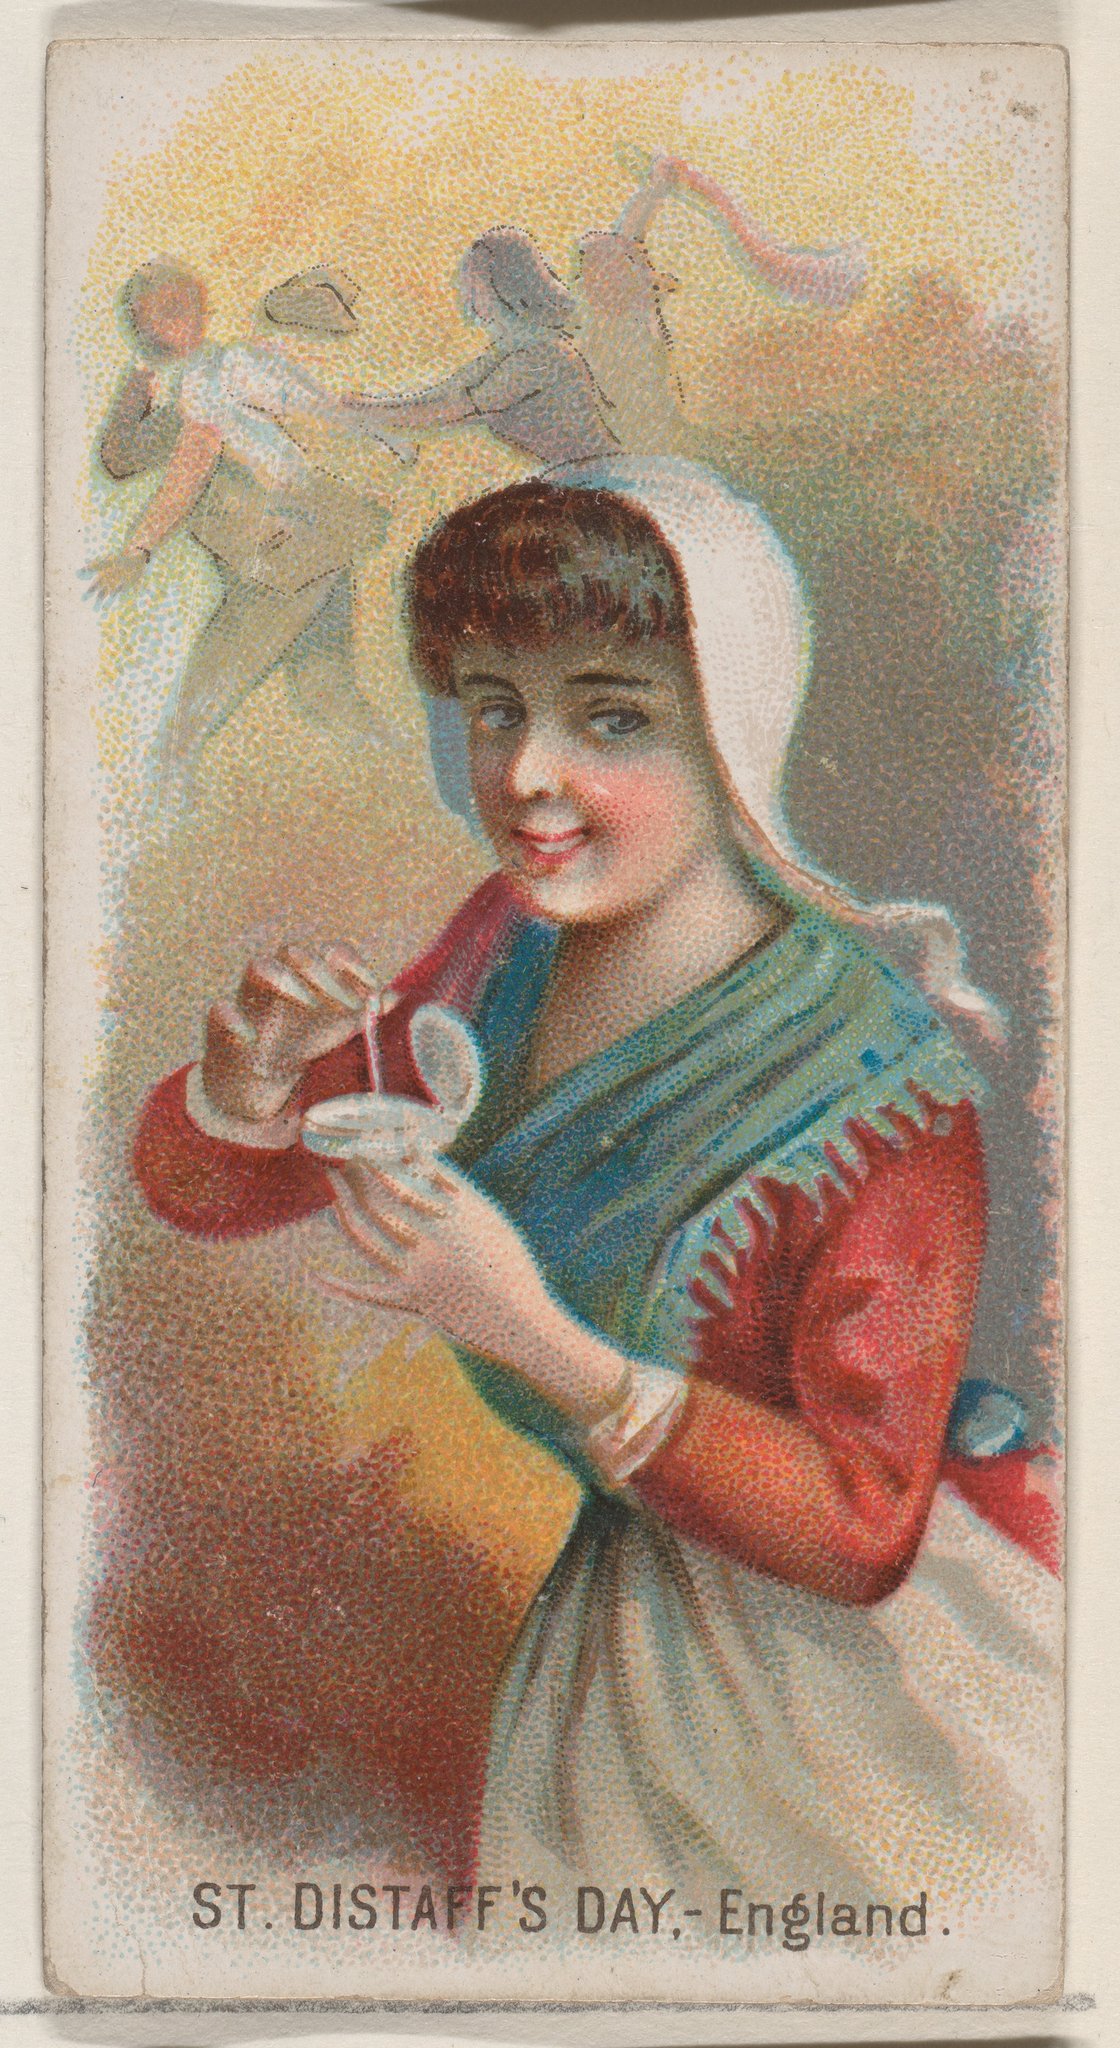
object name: print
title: Saint Distaff's Day, England, from the Holidays series (N80) for Duke brand cigarettes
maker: w. duke, sons & co.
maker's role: publisher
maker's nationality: american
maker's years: 1870-1920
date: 1890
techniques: color lithograph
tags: women